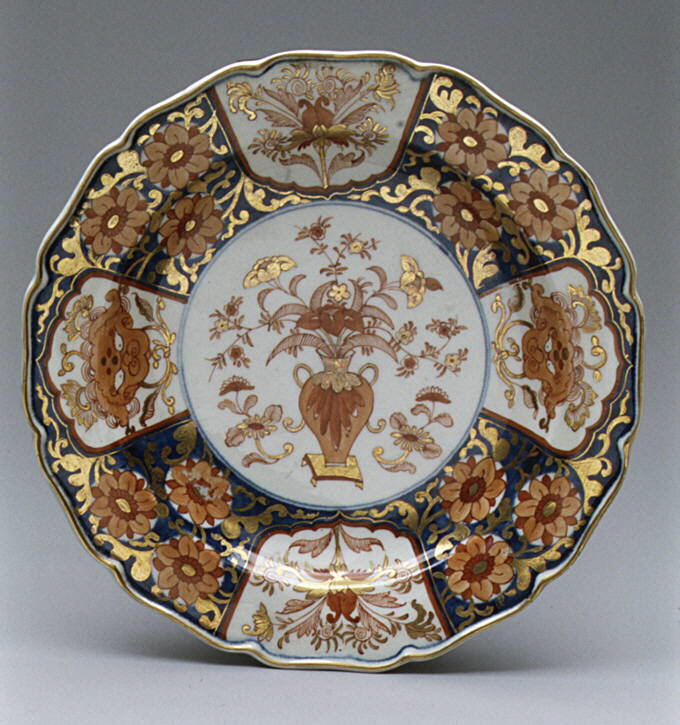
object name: plate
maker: worcester factory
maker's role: factory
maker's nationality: british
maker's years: 1751-2008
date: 1701-1800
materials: soft paste porcelain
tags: flowers